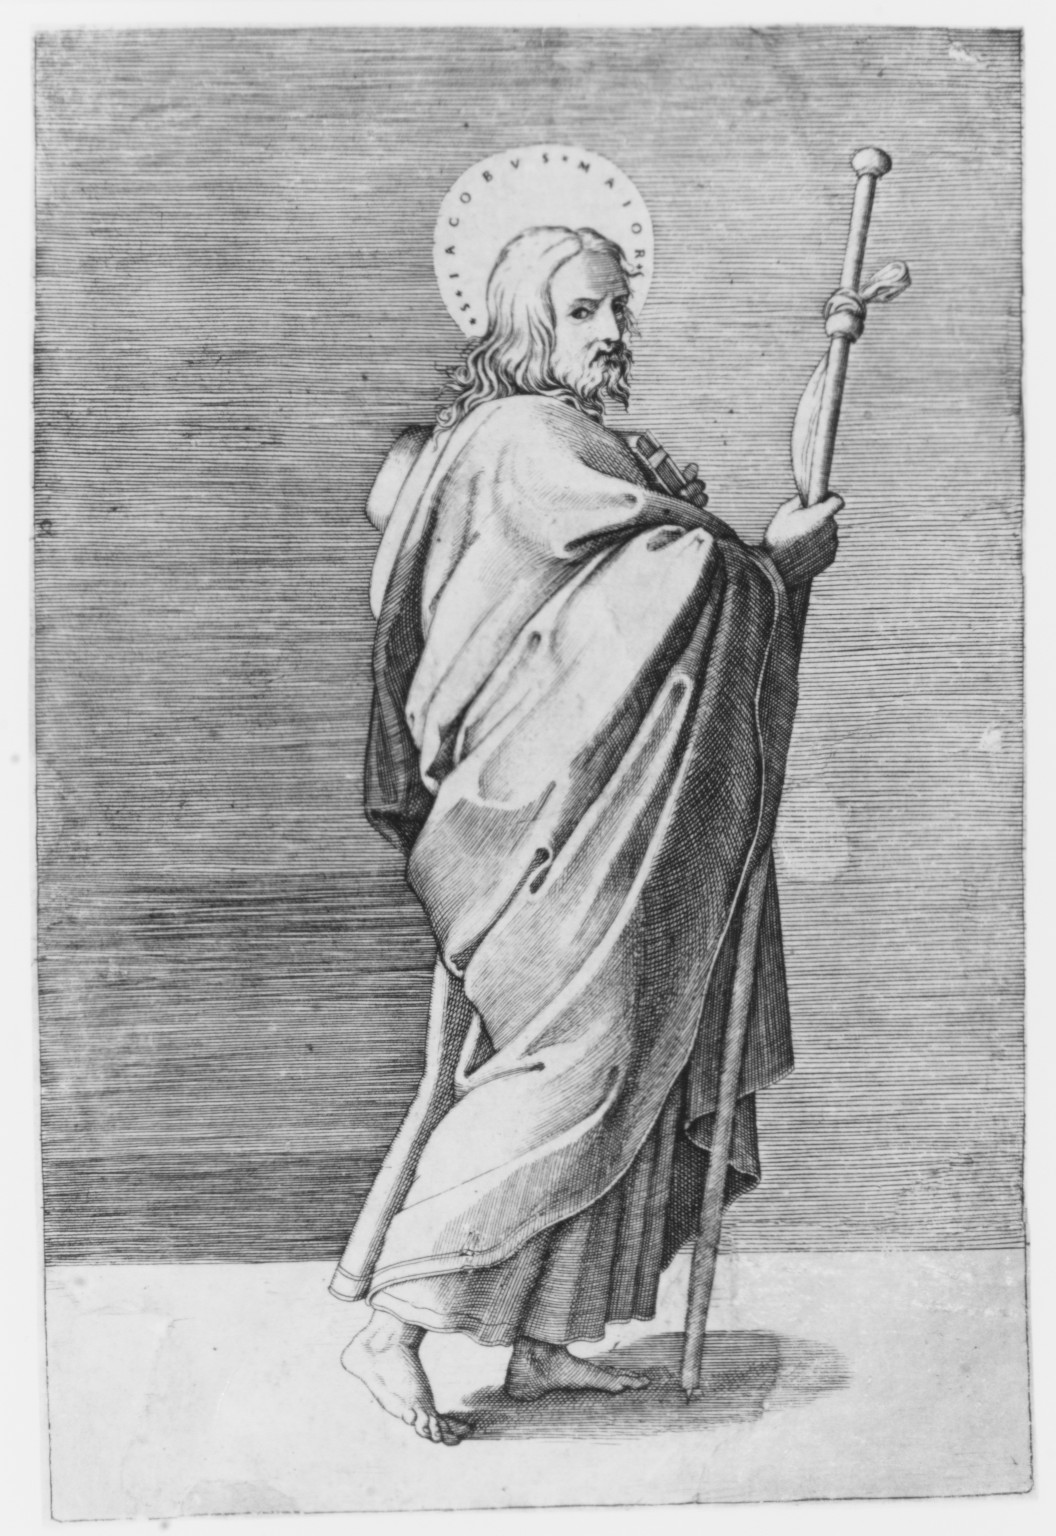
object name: print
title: Saint James the Major turned towards right, holding staff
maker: marcantonio raimondi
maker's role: artist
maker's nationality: italian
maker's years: 1475-1534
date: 1500-1550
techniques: engraving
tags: men,saints